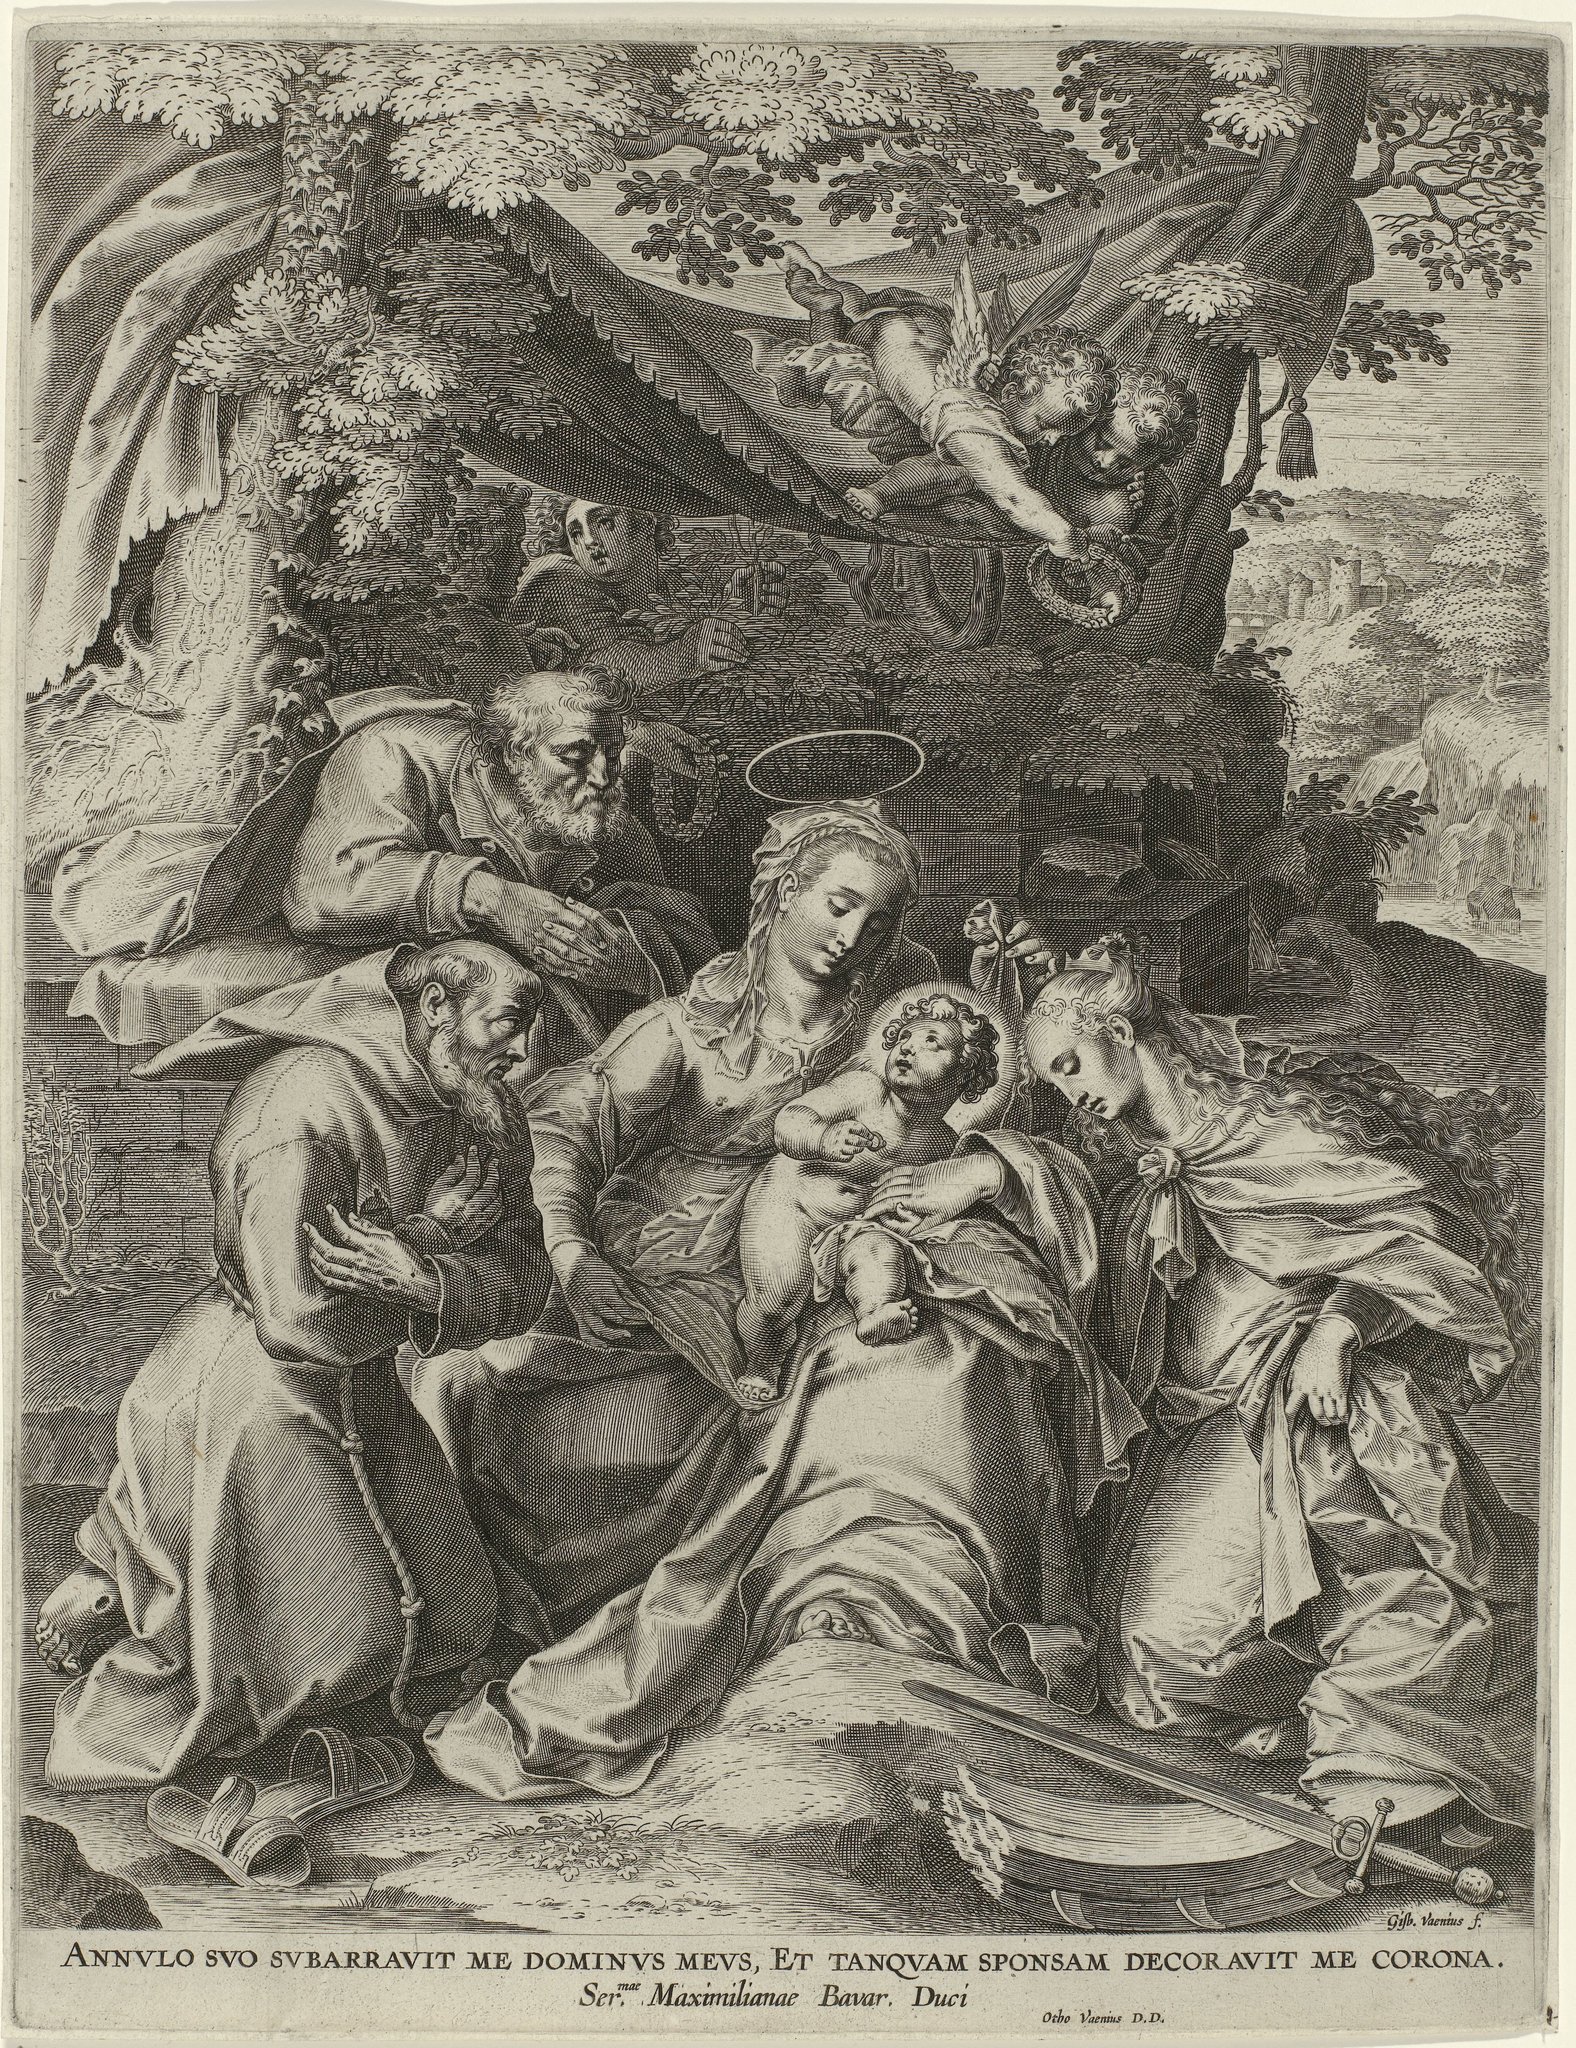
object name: print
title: Mystieke huwelijk van H. Catharina van Alexandrië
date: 1573-1628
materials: paper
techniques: engraving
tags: founder of the order of friars minor (franciscans), francis(cus) of assisi; possible attributes: book, crucifix, lily, skull, stigmata, the mystic marriage of st. catherine of alexandria with the infant christ: the christ-child puts a ring on her finger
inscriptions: collector's mark: Lugt 10, collector's mark: Lugt 11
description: Maria met Kind op schoot, zittend in een landschap onder een baldakijn. Schuin achter hen Jozef. Rechts zit de heilige Catharina geknield voor het Christuskind dat haar een ring aanbiedt. Boven haar hoofd een twee engelen met een lauwerkrans. Op de grond liggen haar attributen zwaard en gebroken rad. Links zit de heilige Franciscus.